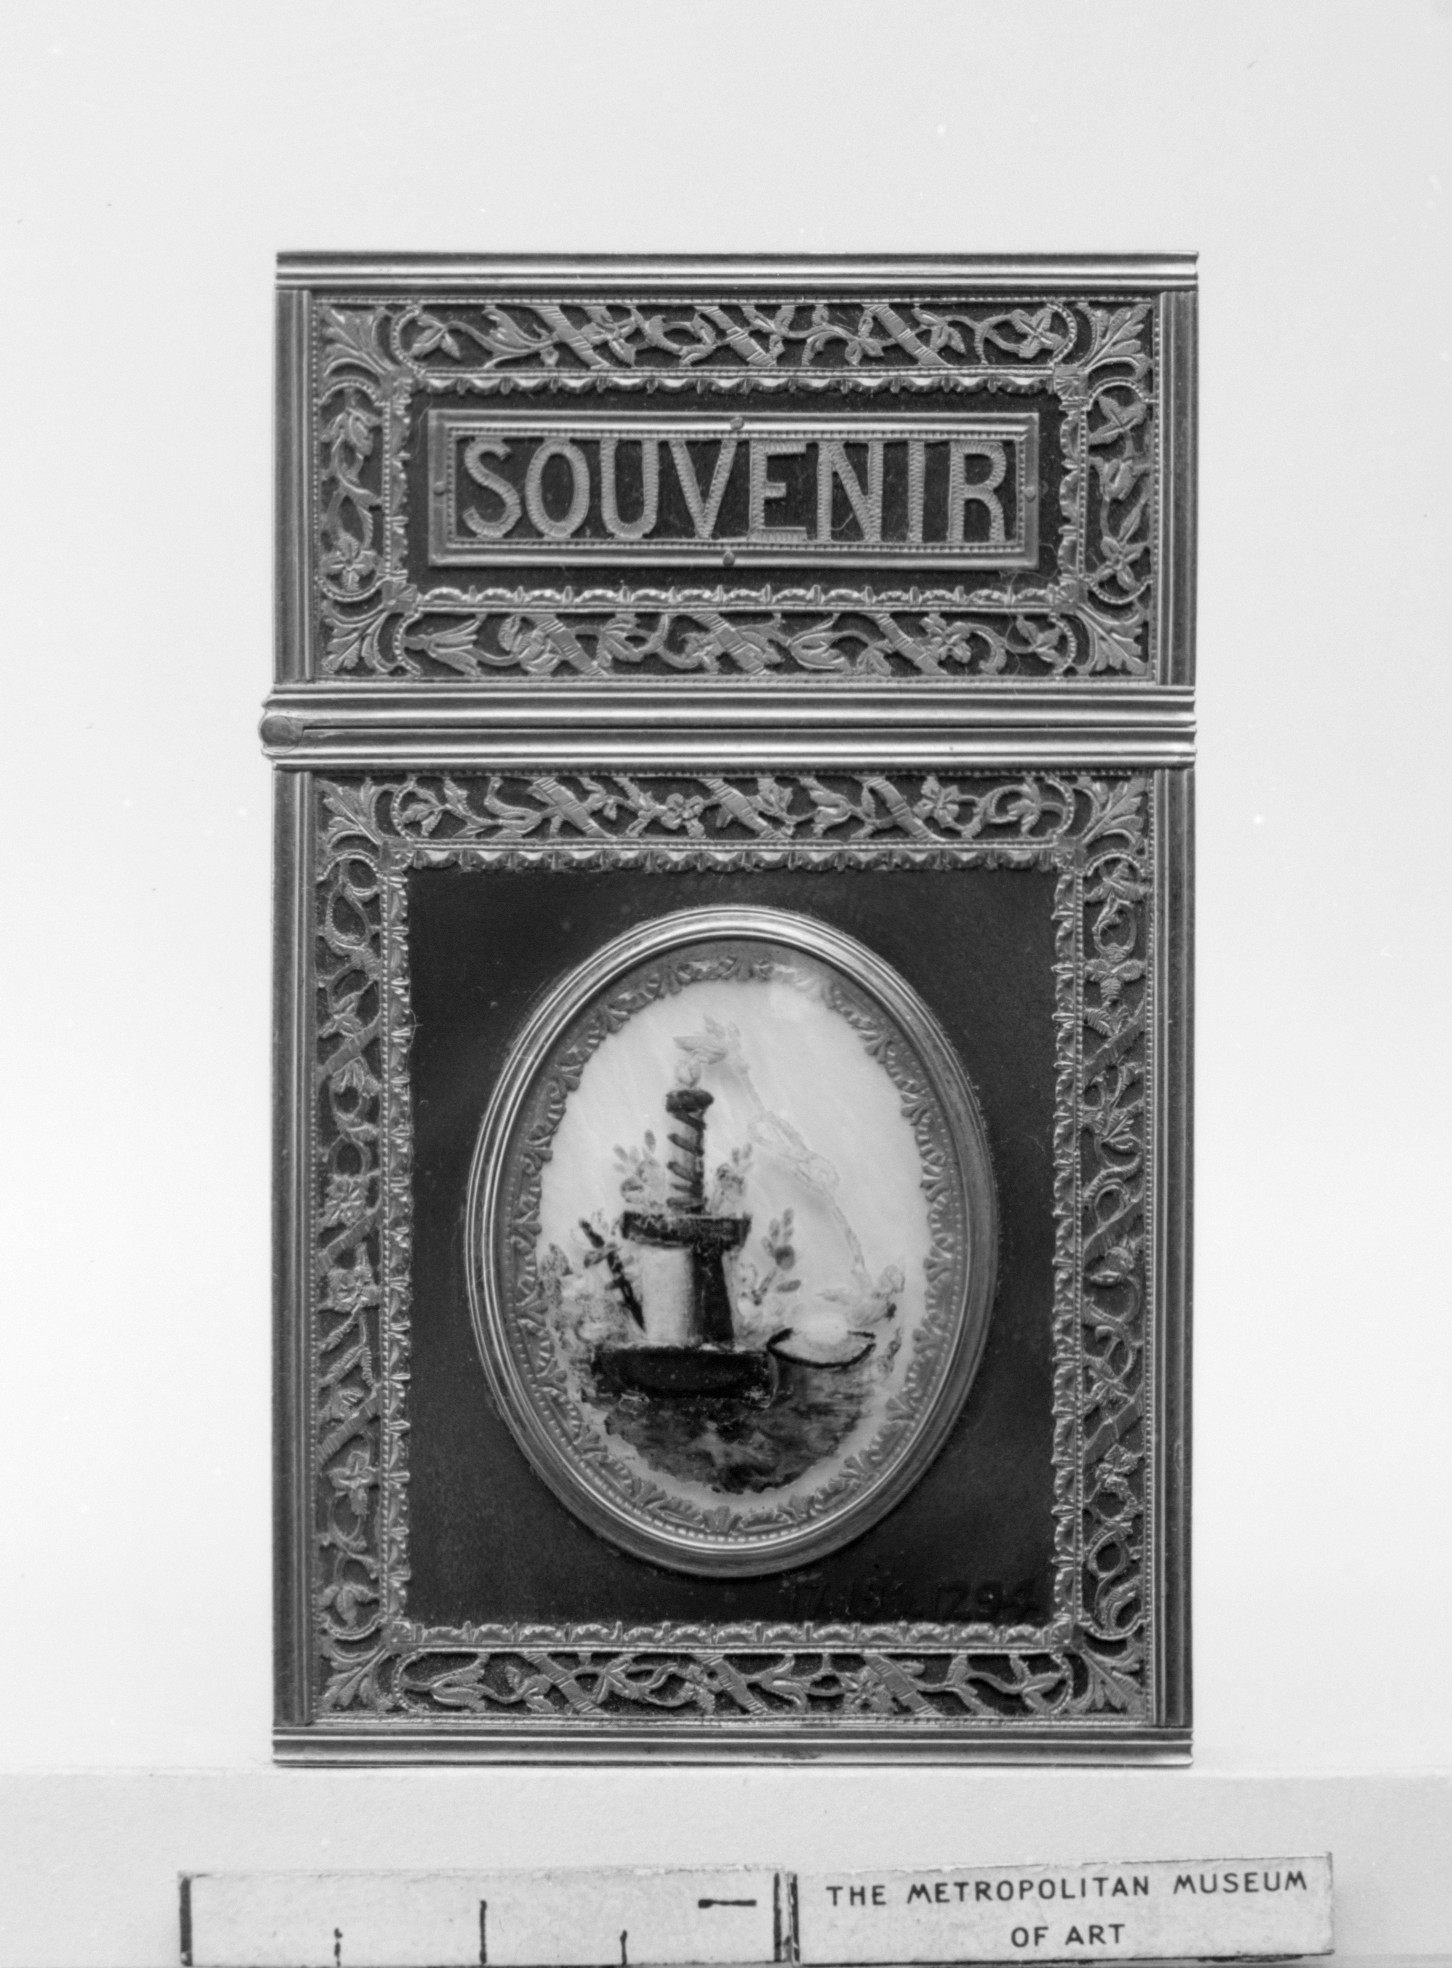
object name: souvenir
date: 1781-1782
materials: diamond, gold, ivory, jasper, mother of pearl